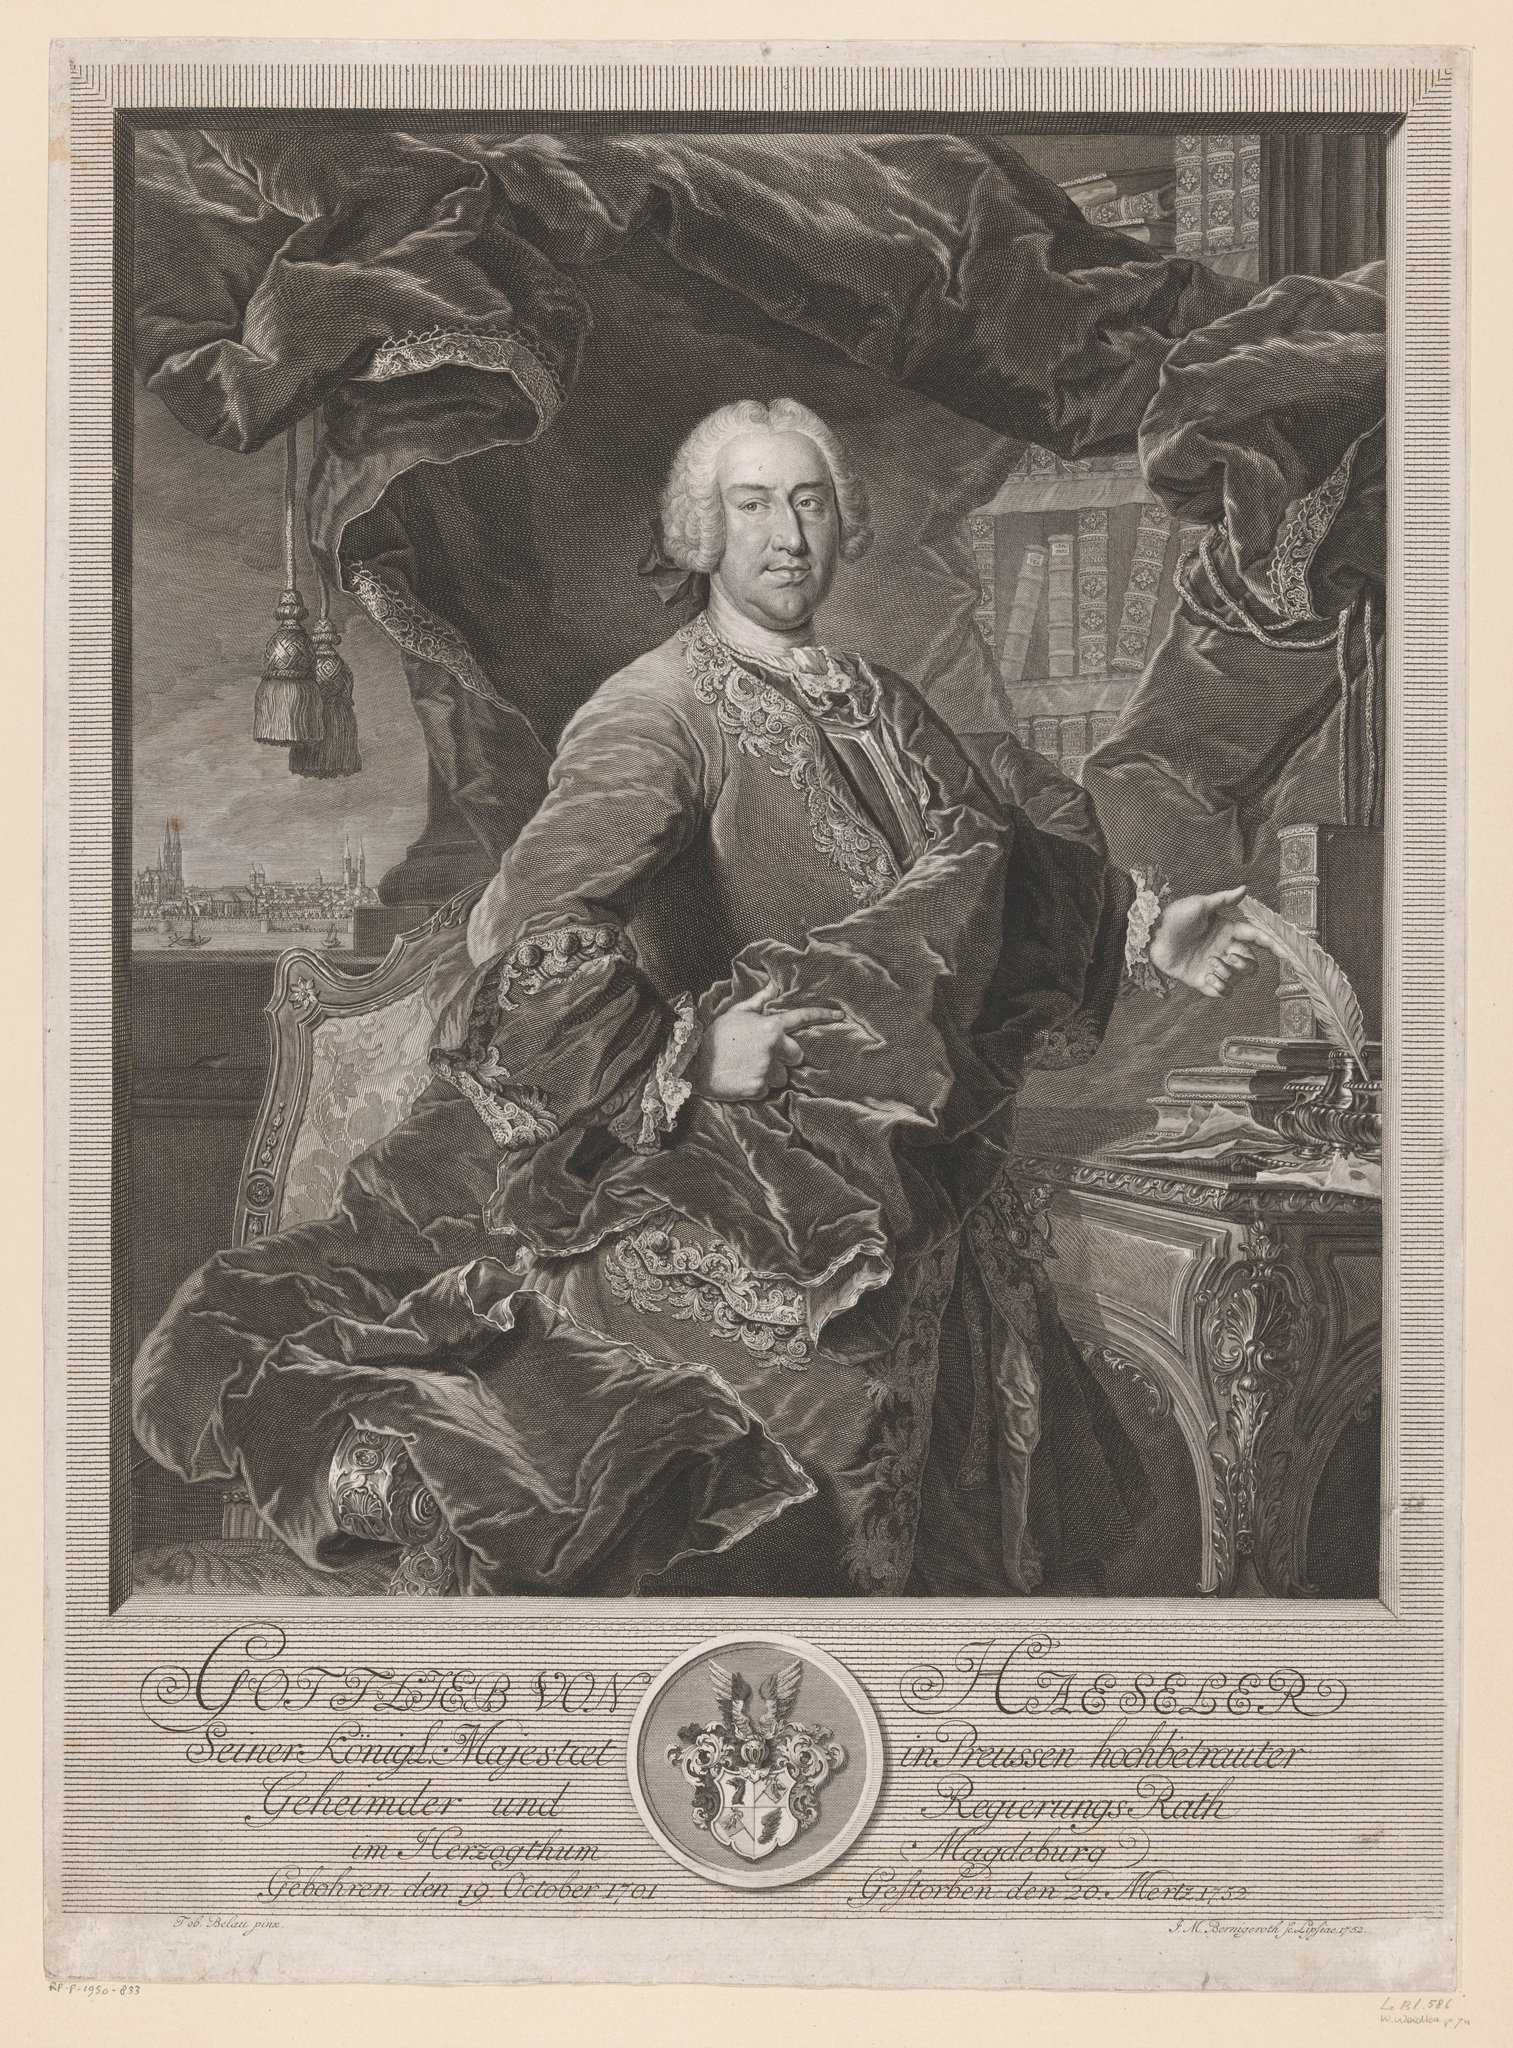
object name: print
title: Maaltijd van Esther, Ahasverus en Haman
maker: monogrammist ddc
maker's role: print maker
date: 1526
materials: paper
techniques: engraving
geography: low countries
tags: esther's banquet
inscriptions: collector's mark: Lugt 2228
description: Afdruk van zilverplaatje, verso (2). Esther en Ahasverus aan tafel tegenover Haman. Op achtergrond wordt galg neergezet.